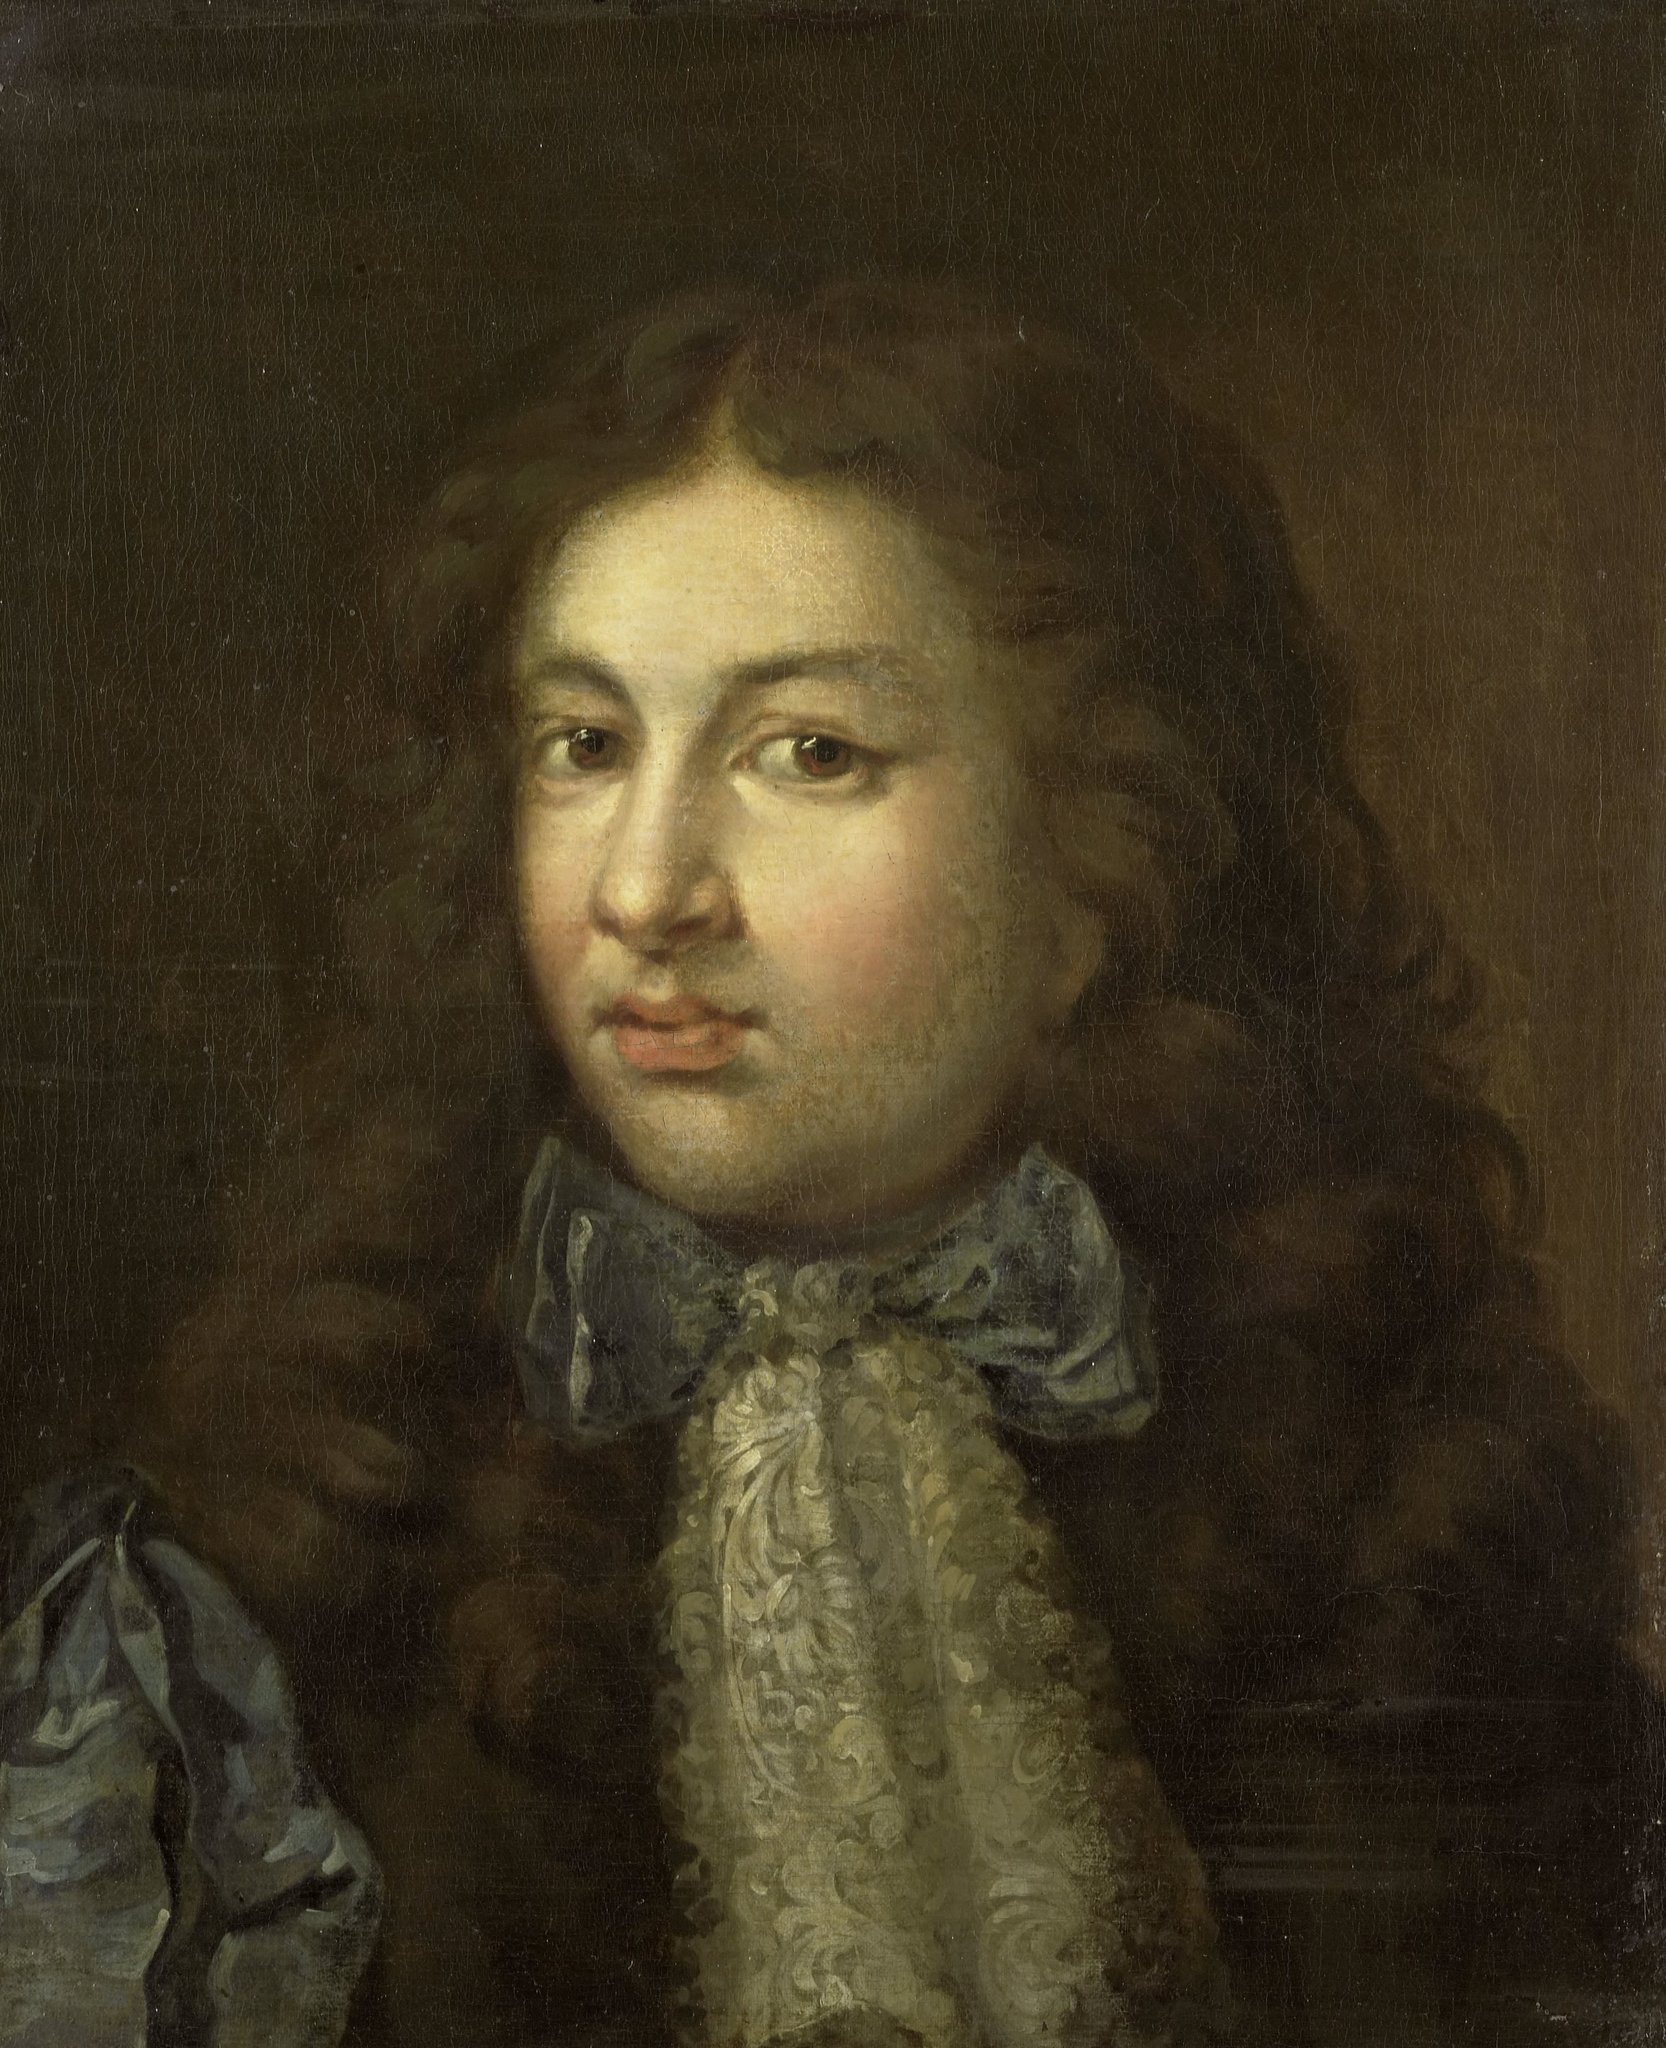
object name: painting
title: Portrait of Thedoor Netscher (1661-1728), the Artist's Oldest Son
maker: caspar netscher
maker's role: draughtsman, painter, print maker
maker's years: 1639-1684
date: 1671-1684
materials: canvas, oil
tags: theodorus netscher, historical persons, portrait, self-portrait of painter, portrait, self-portrait of artist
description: Portret van Theodoor Netscher, de oudste zoon van de schilder. Buste, het hoofd naar links, met een grote strik om de hals.